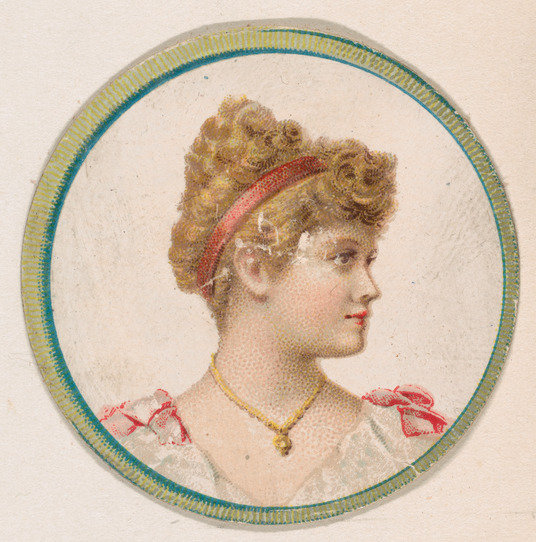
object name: print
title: Woman wearing pink ribbon in hair, from the Novelties series (N228, Type 2) issued by Kinney Bros.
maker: kinney brothers tobacco company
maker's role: publisher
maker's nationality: american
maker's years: 1869-2011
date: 1889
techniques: color lithograph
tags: profiles,women